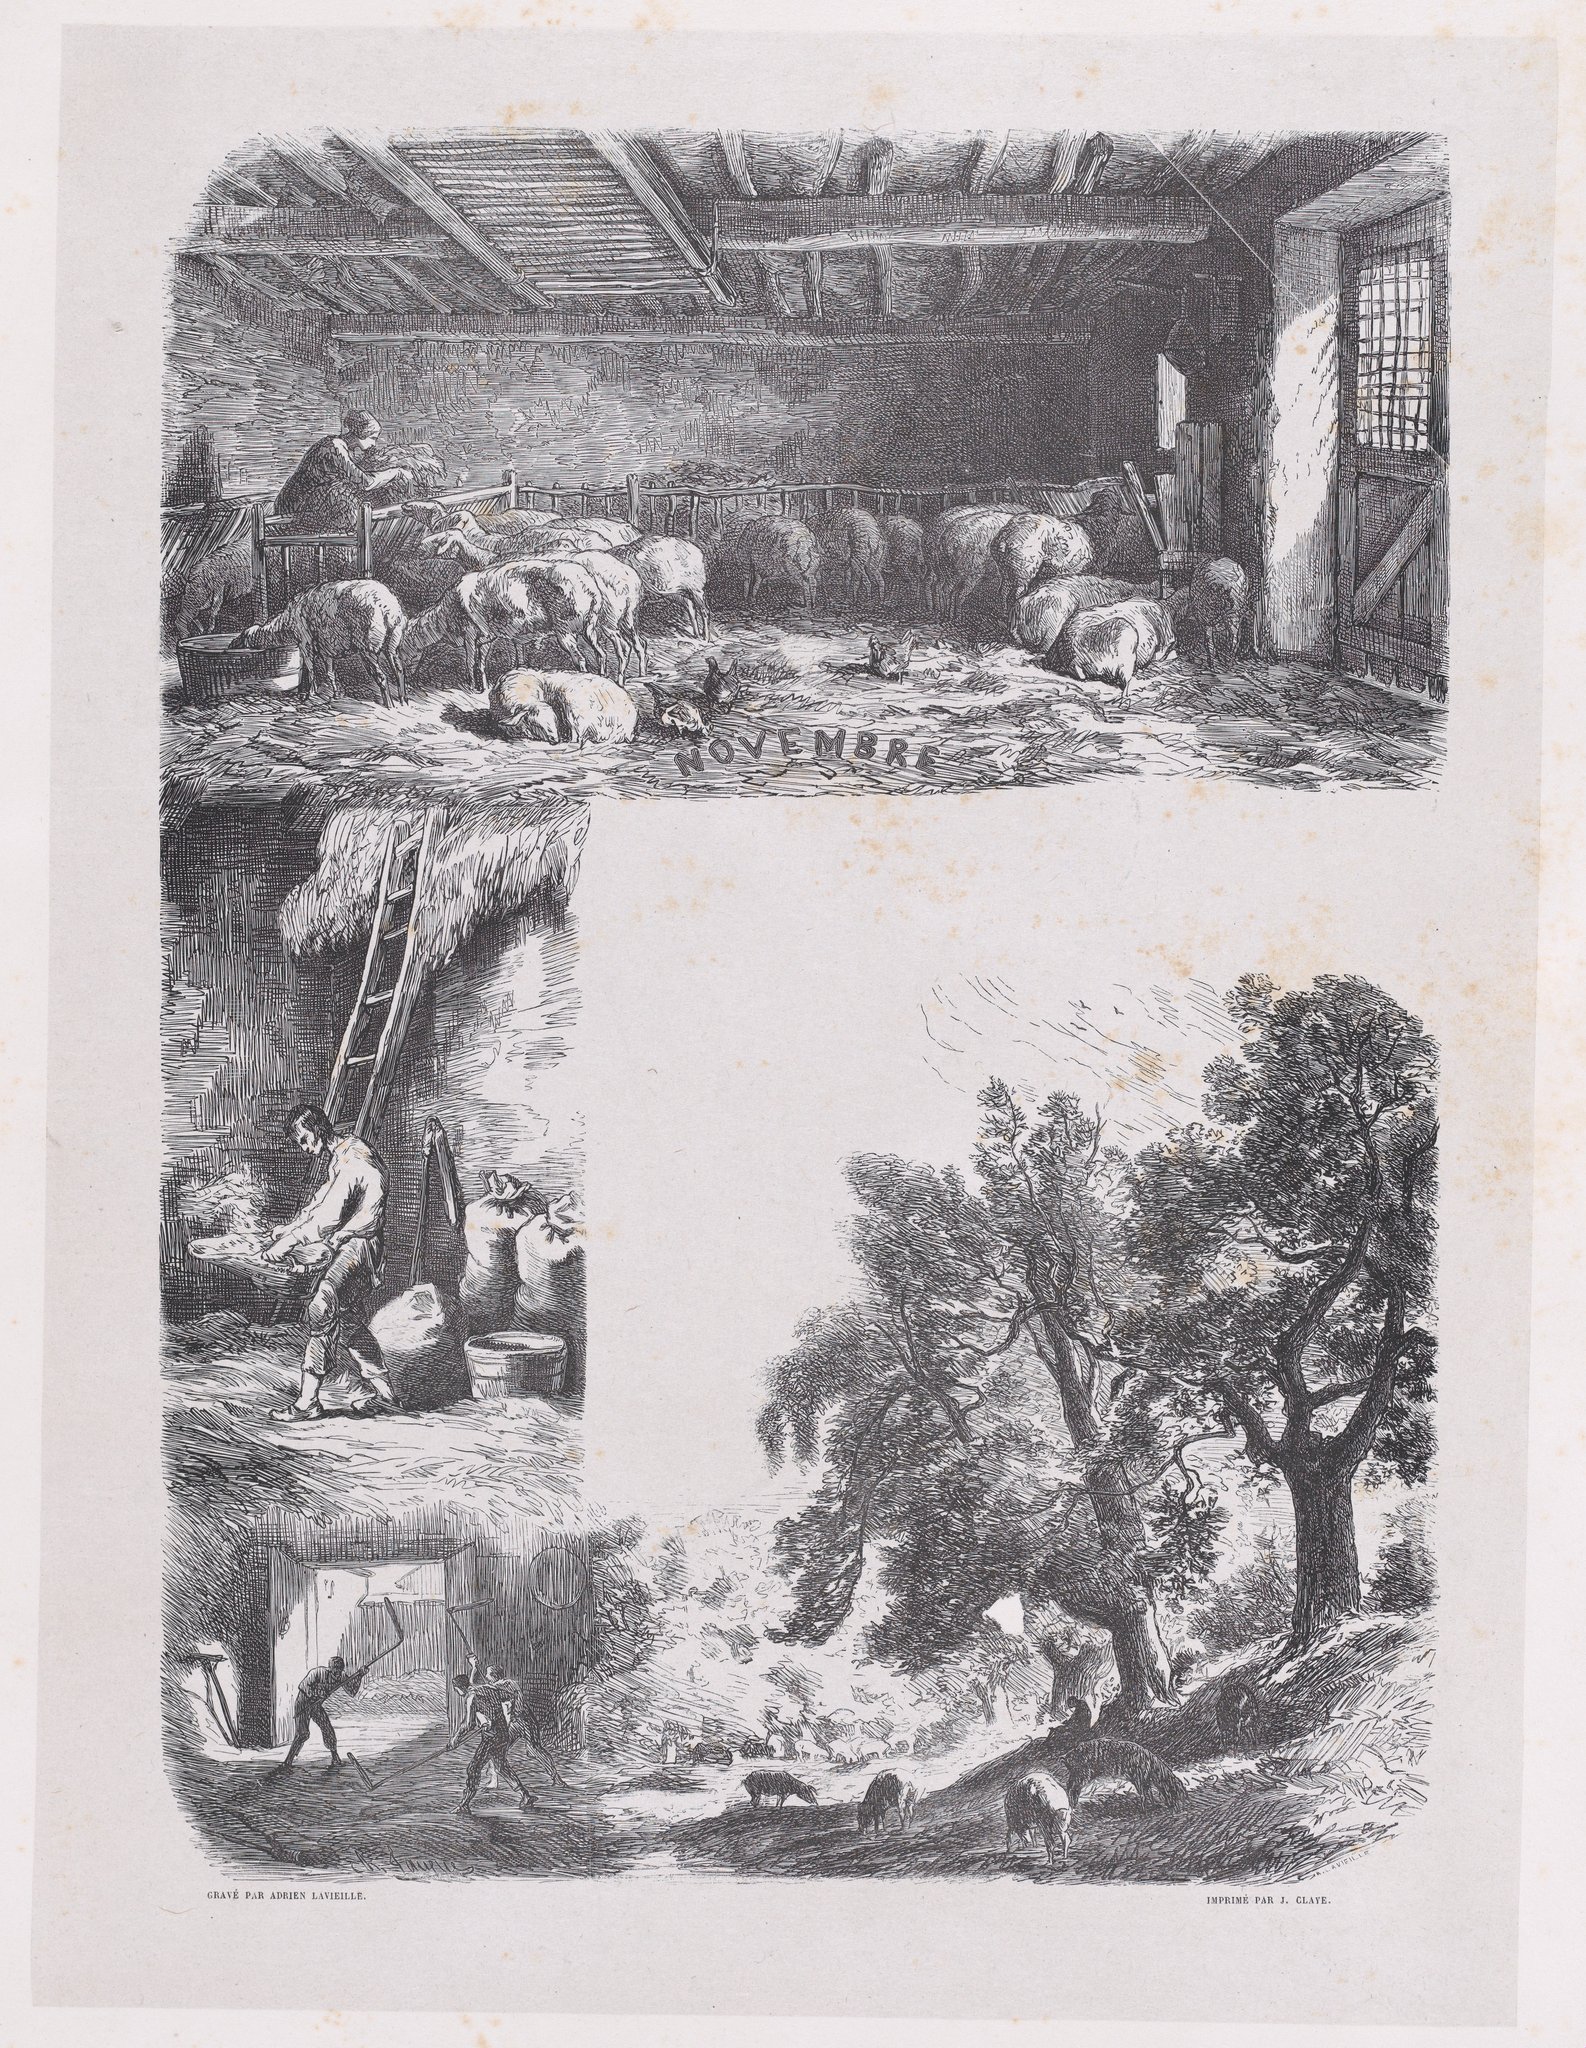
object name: print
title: November, from "Album of Rustic Subjects"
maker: charles émile jacque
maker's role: artist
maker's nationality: french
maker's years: 1813-1894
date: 1859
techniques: engraving